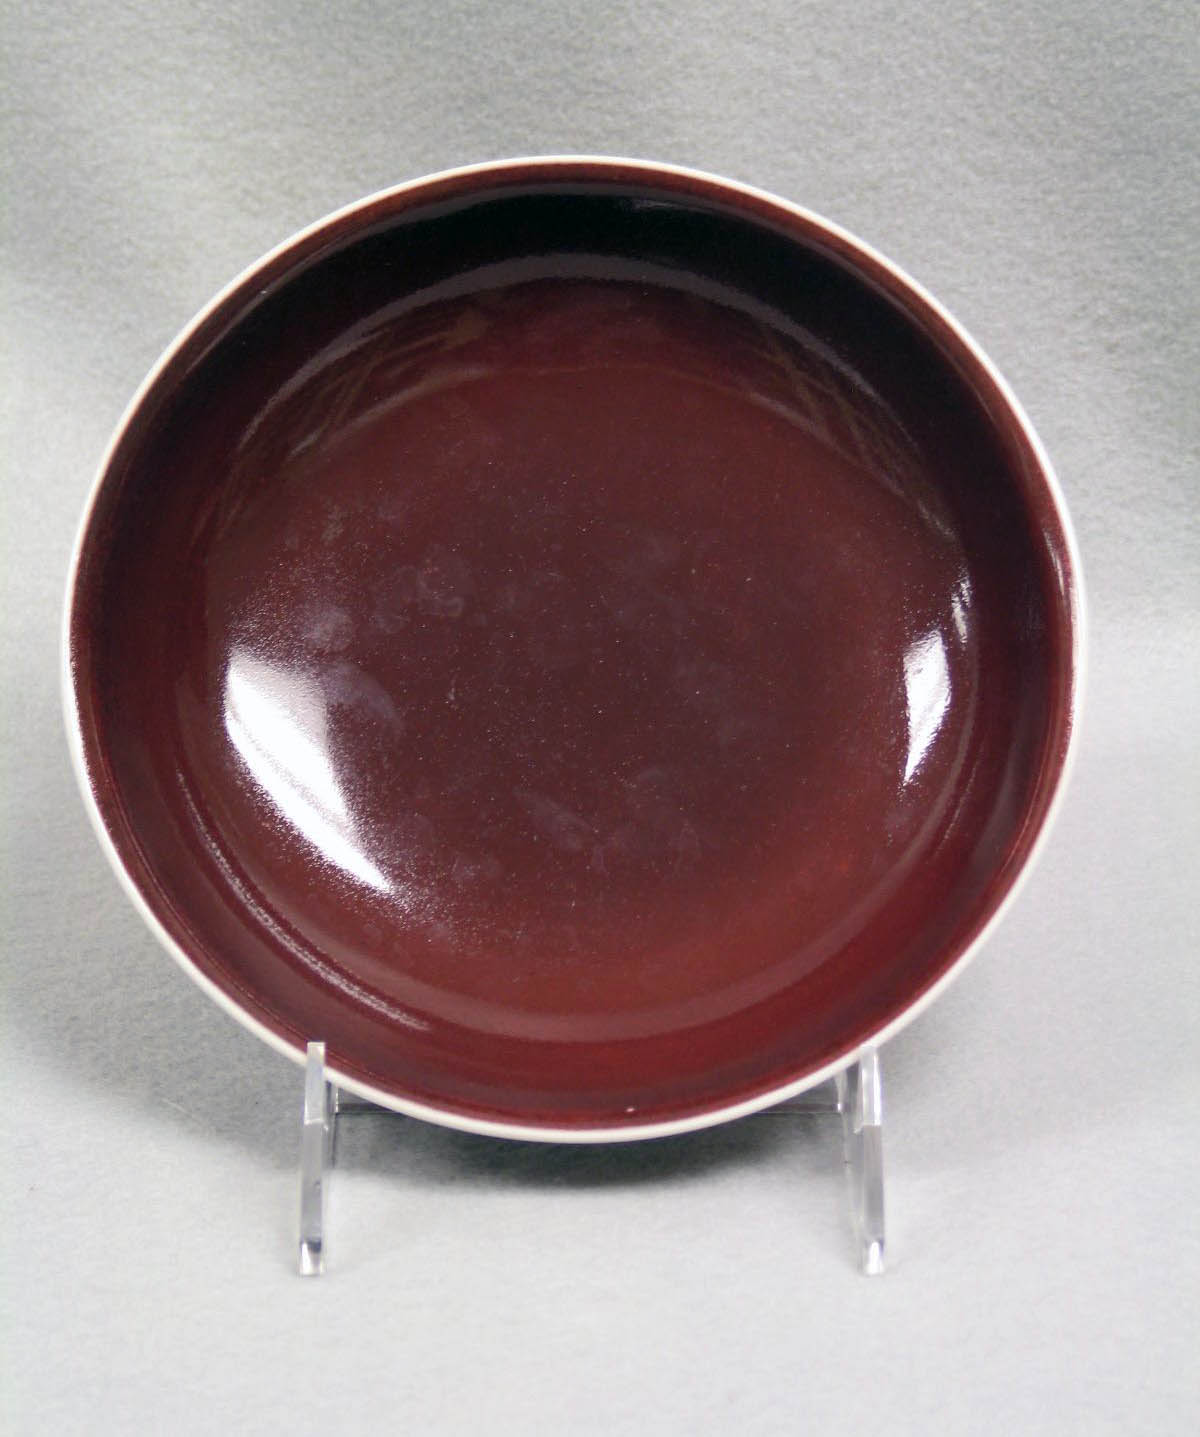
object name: dish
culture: chinese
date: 1736-1795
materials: copper, glaze, porcelain